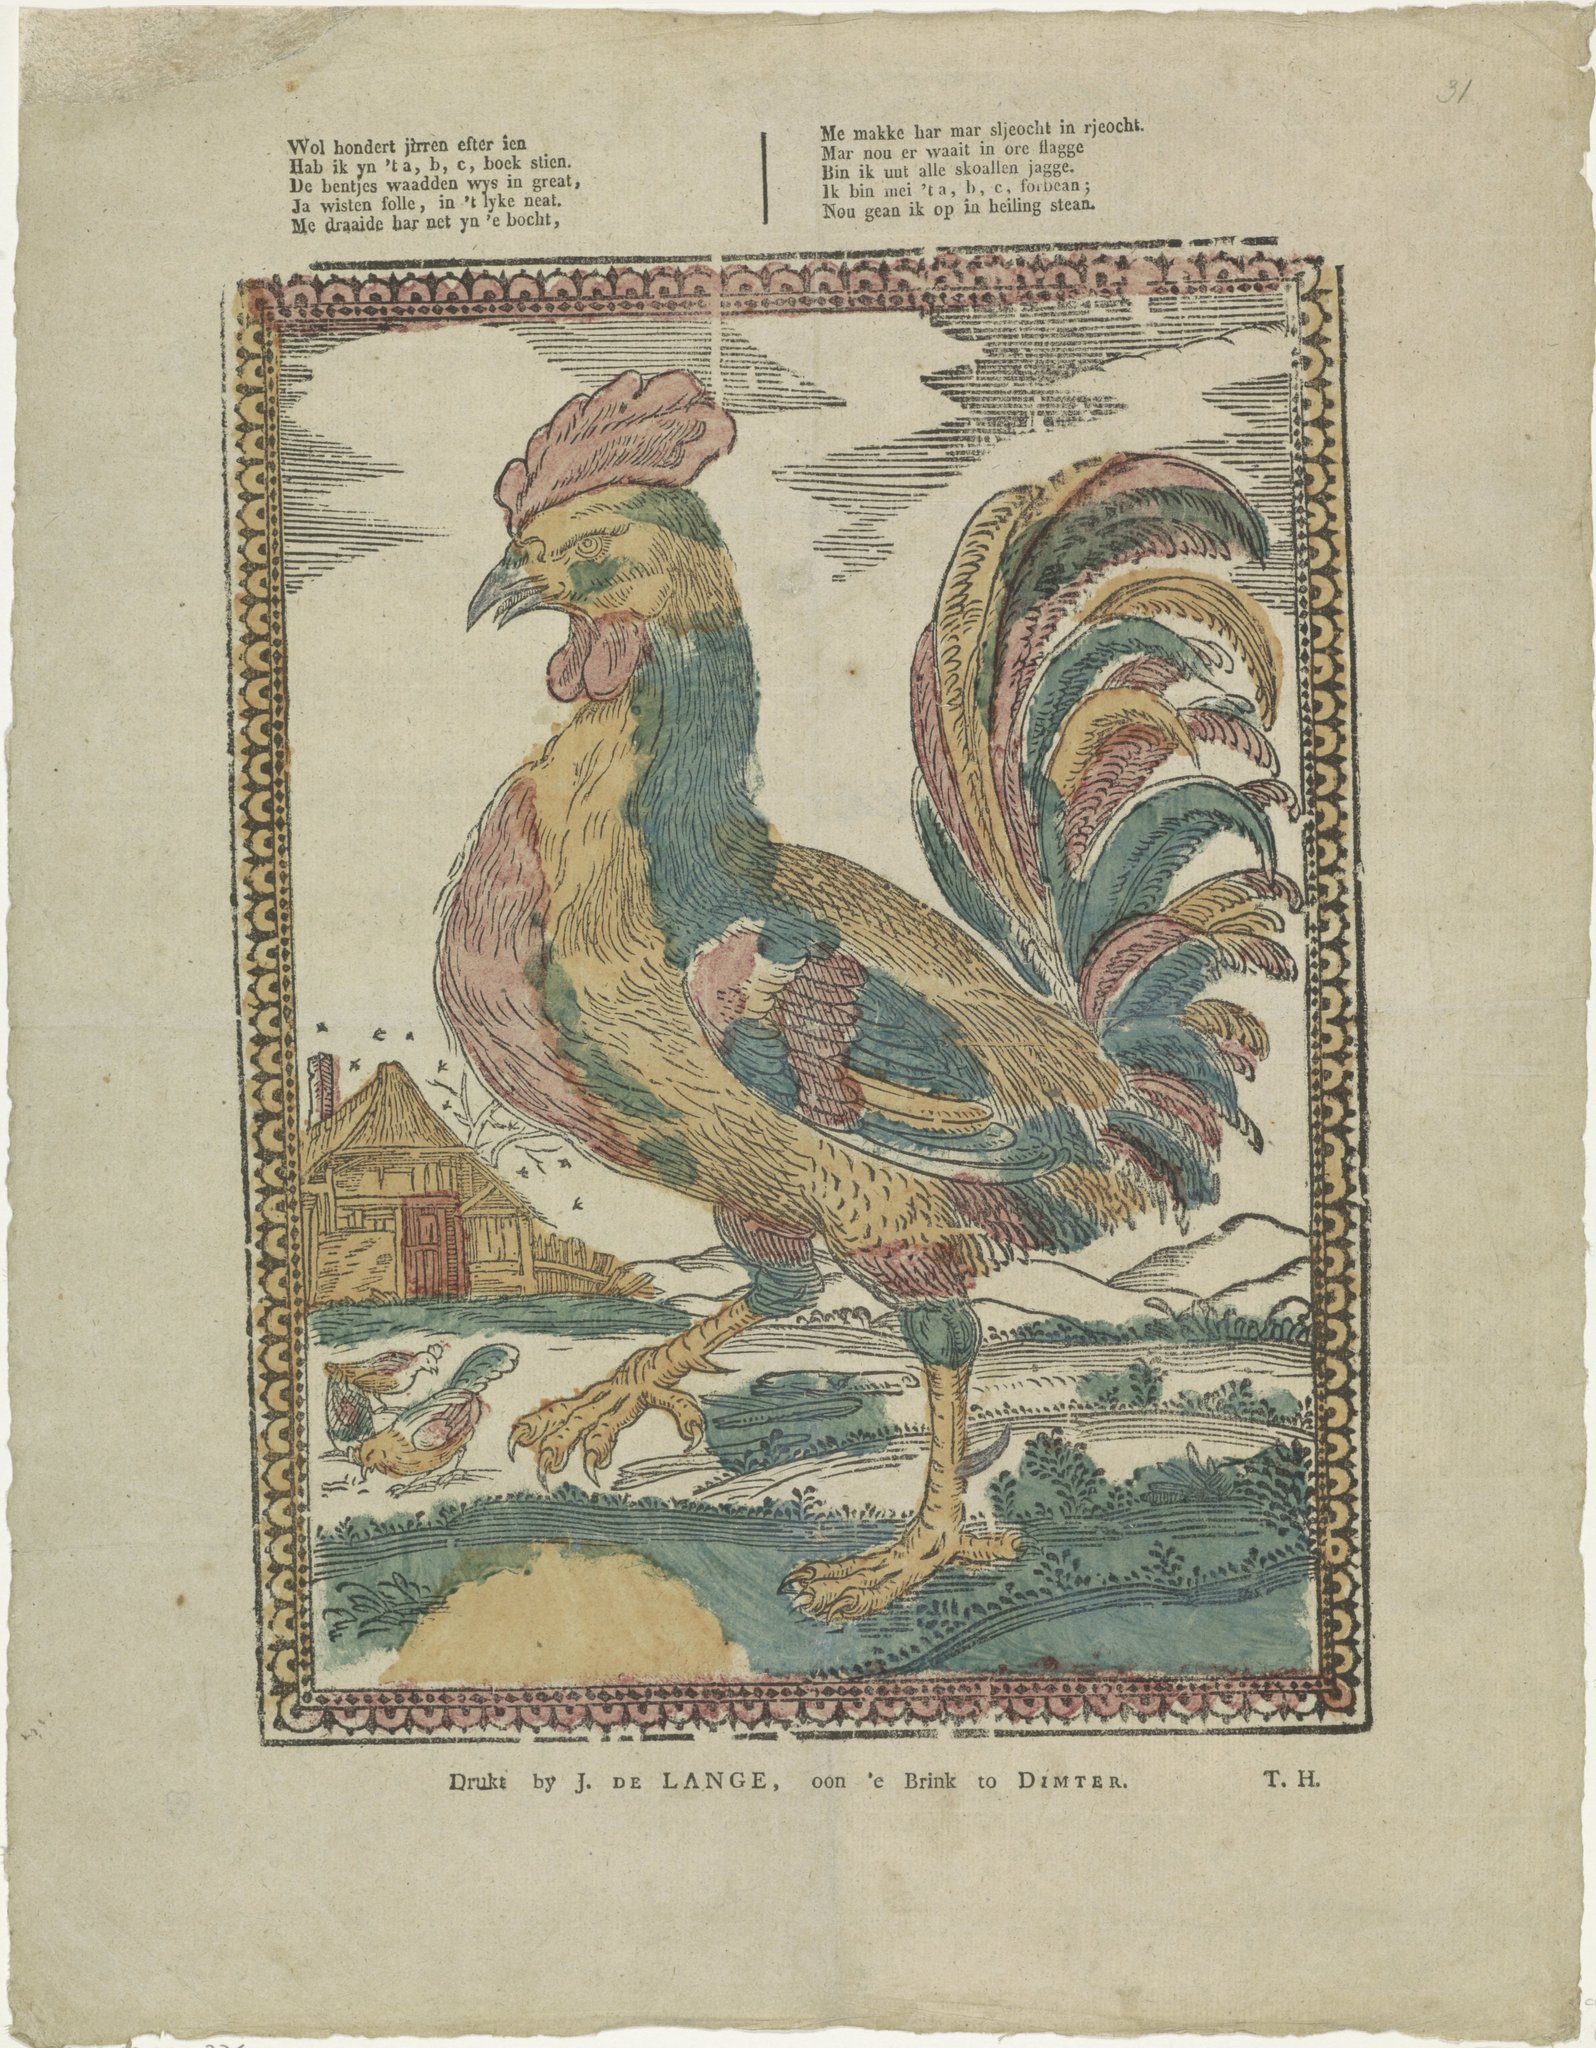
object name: popular print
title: Wol hondert jirren ester ien / Hab ik yn 't a, b, c, boek stien [(...)]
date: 1822-1849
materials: paper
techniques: colour, letterpress printing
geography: netherlands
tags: fowl (cock, hen, chicken, etc.)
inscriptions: inscription: ‘Jeltje Jans [...]beek / Fokke de Zee’, collector's mark: Lugt 2760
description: Blad met een grote voorstelling van een haan. Op de achtergrond twee kippen en een boerderij. De voorstelling is gevat in een sierlijst. Boven een achtregelig vers (titel) in twee kolommen in het Fries.